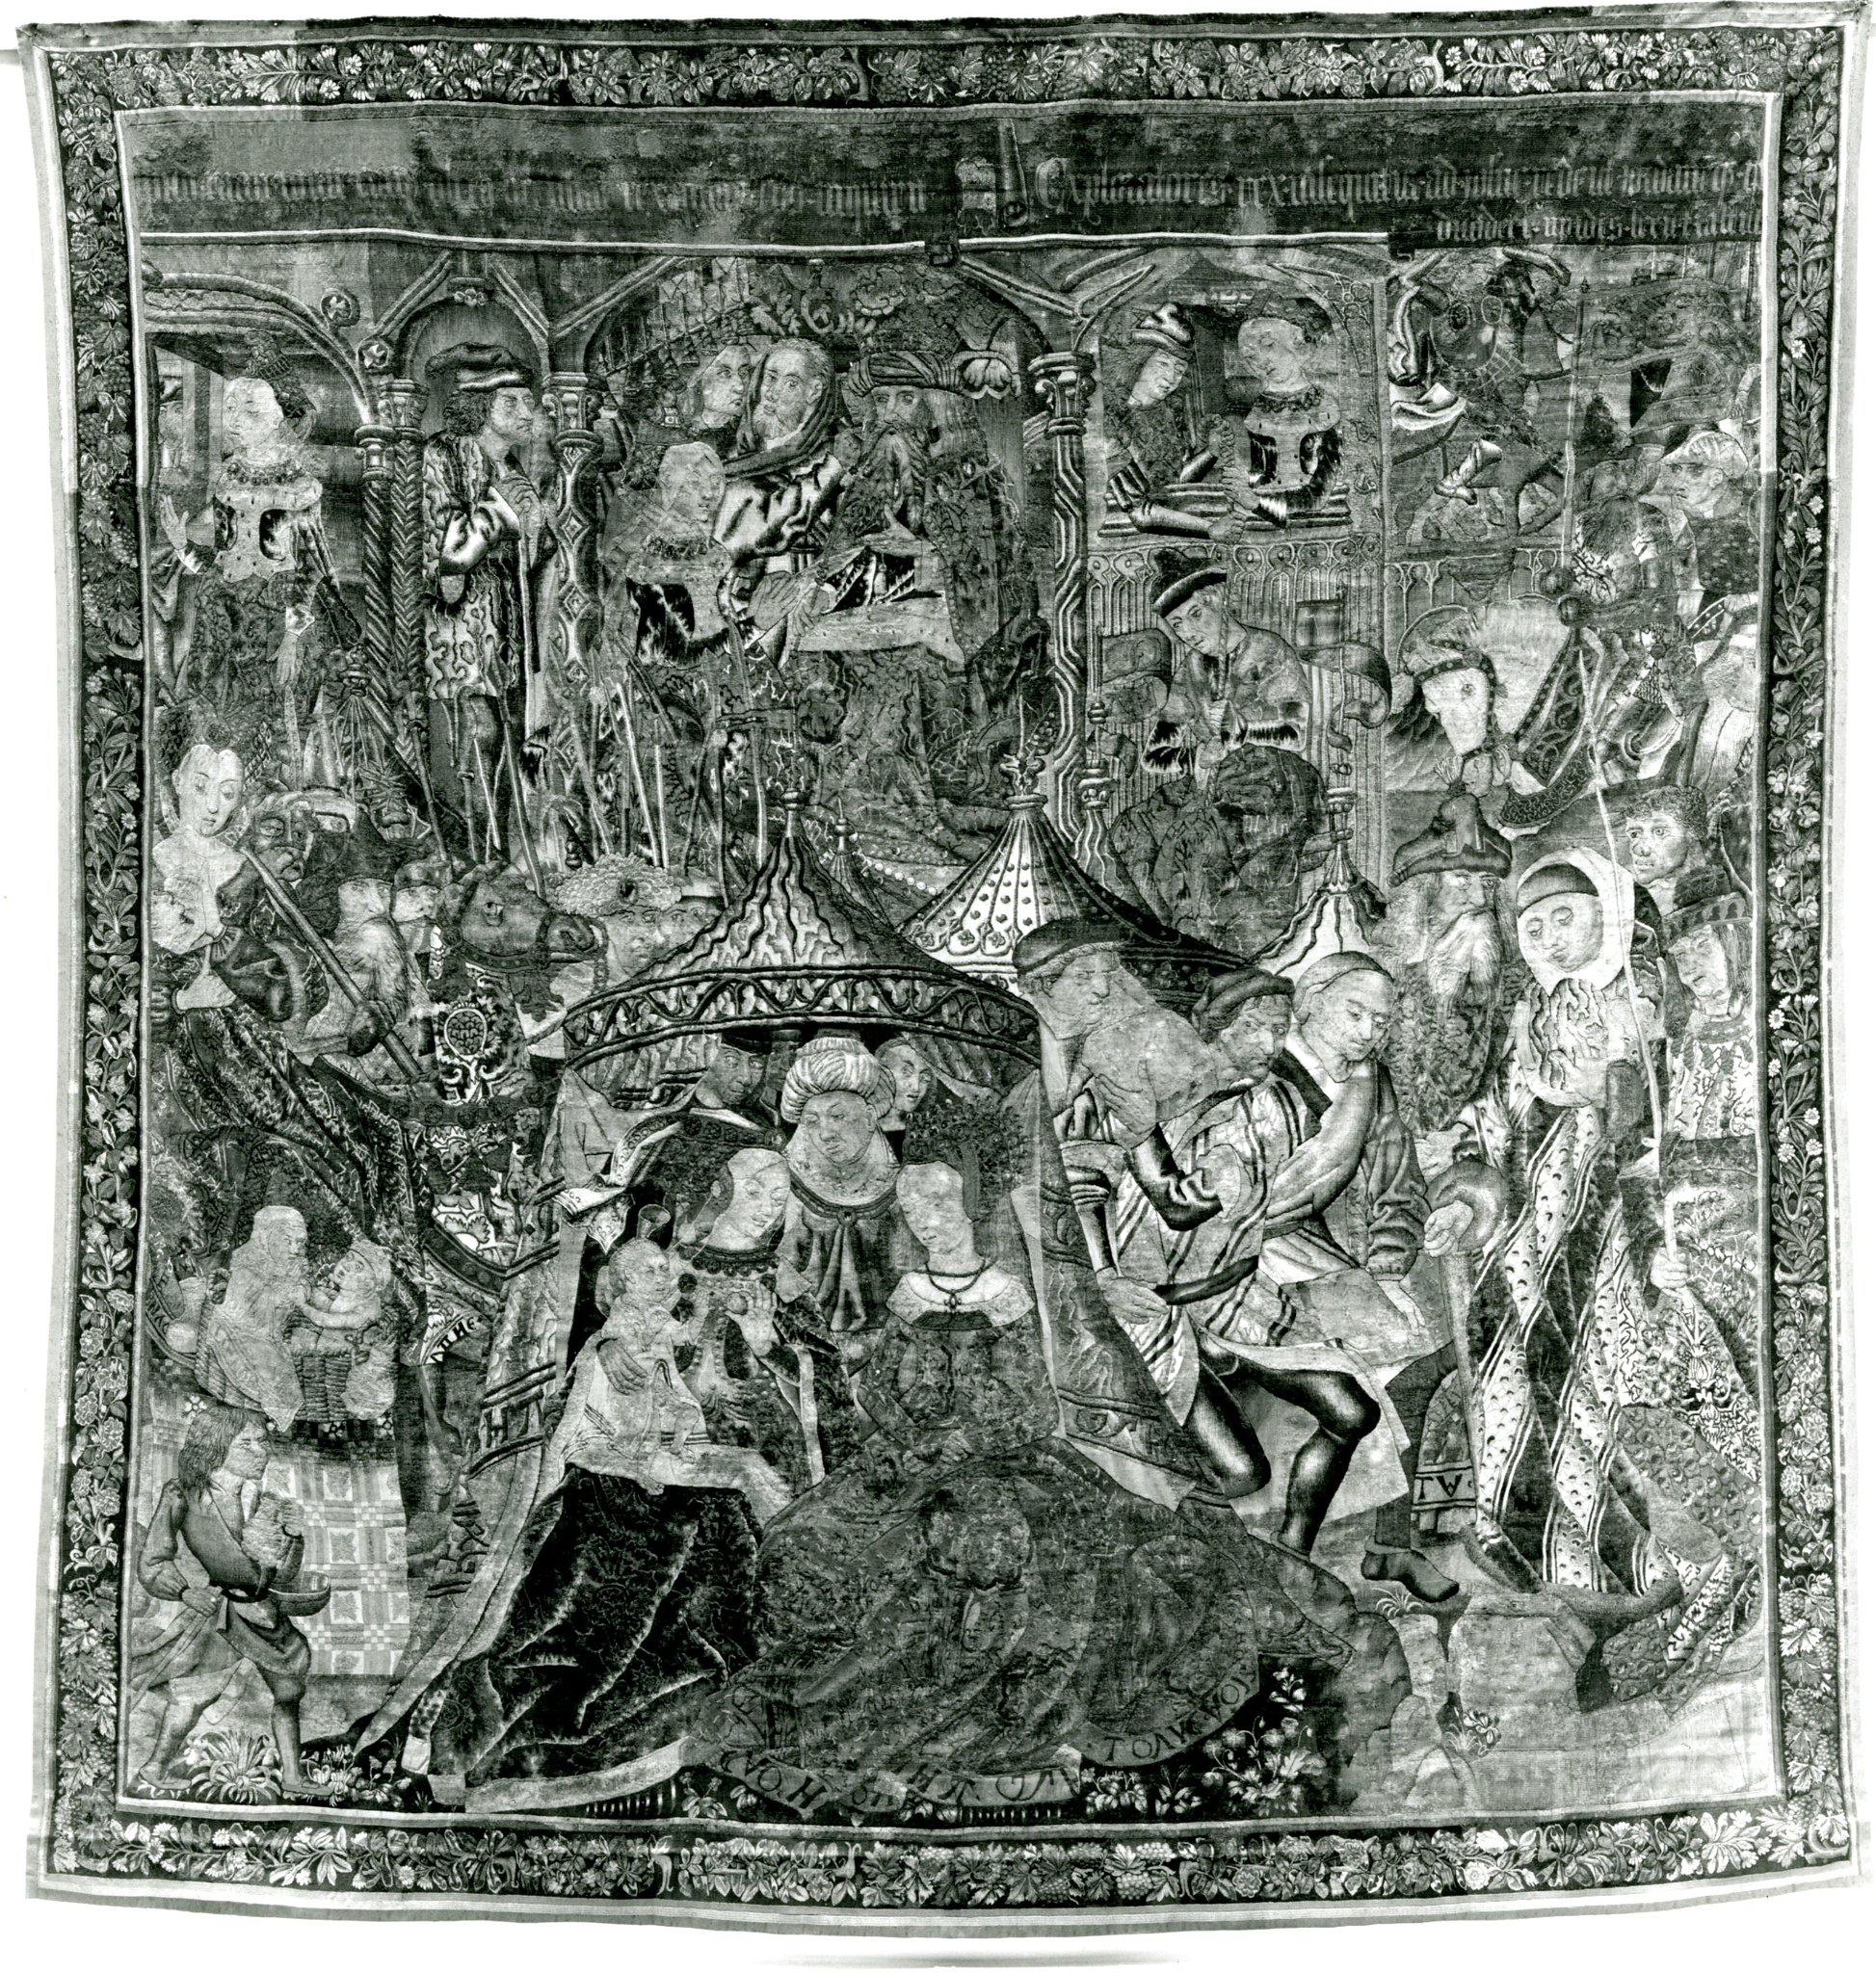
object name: tapestry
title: Episode in the life of Joshua-Rahab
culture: south netherlandish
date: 1401-1500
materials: wool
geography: tournai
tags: men,women,joshua